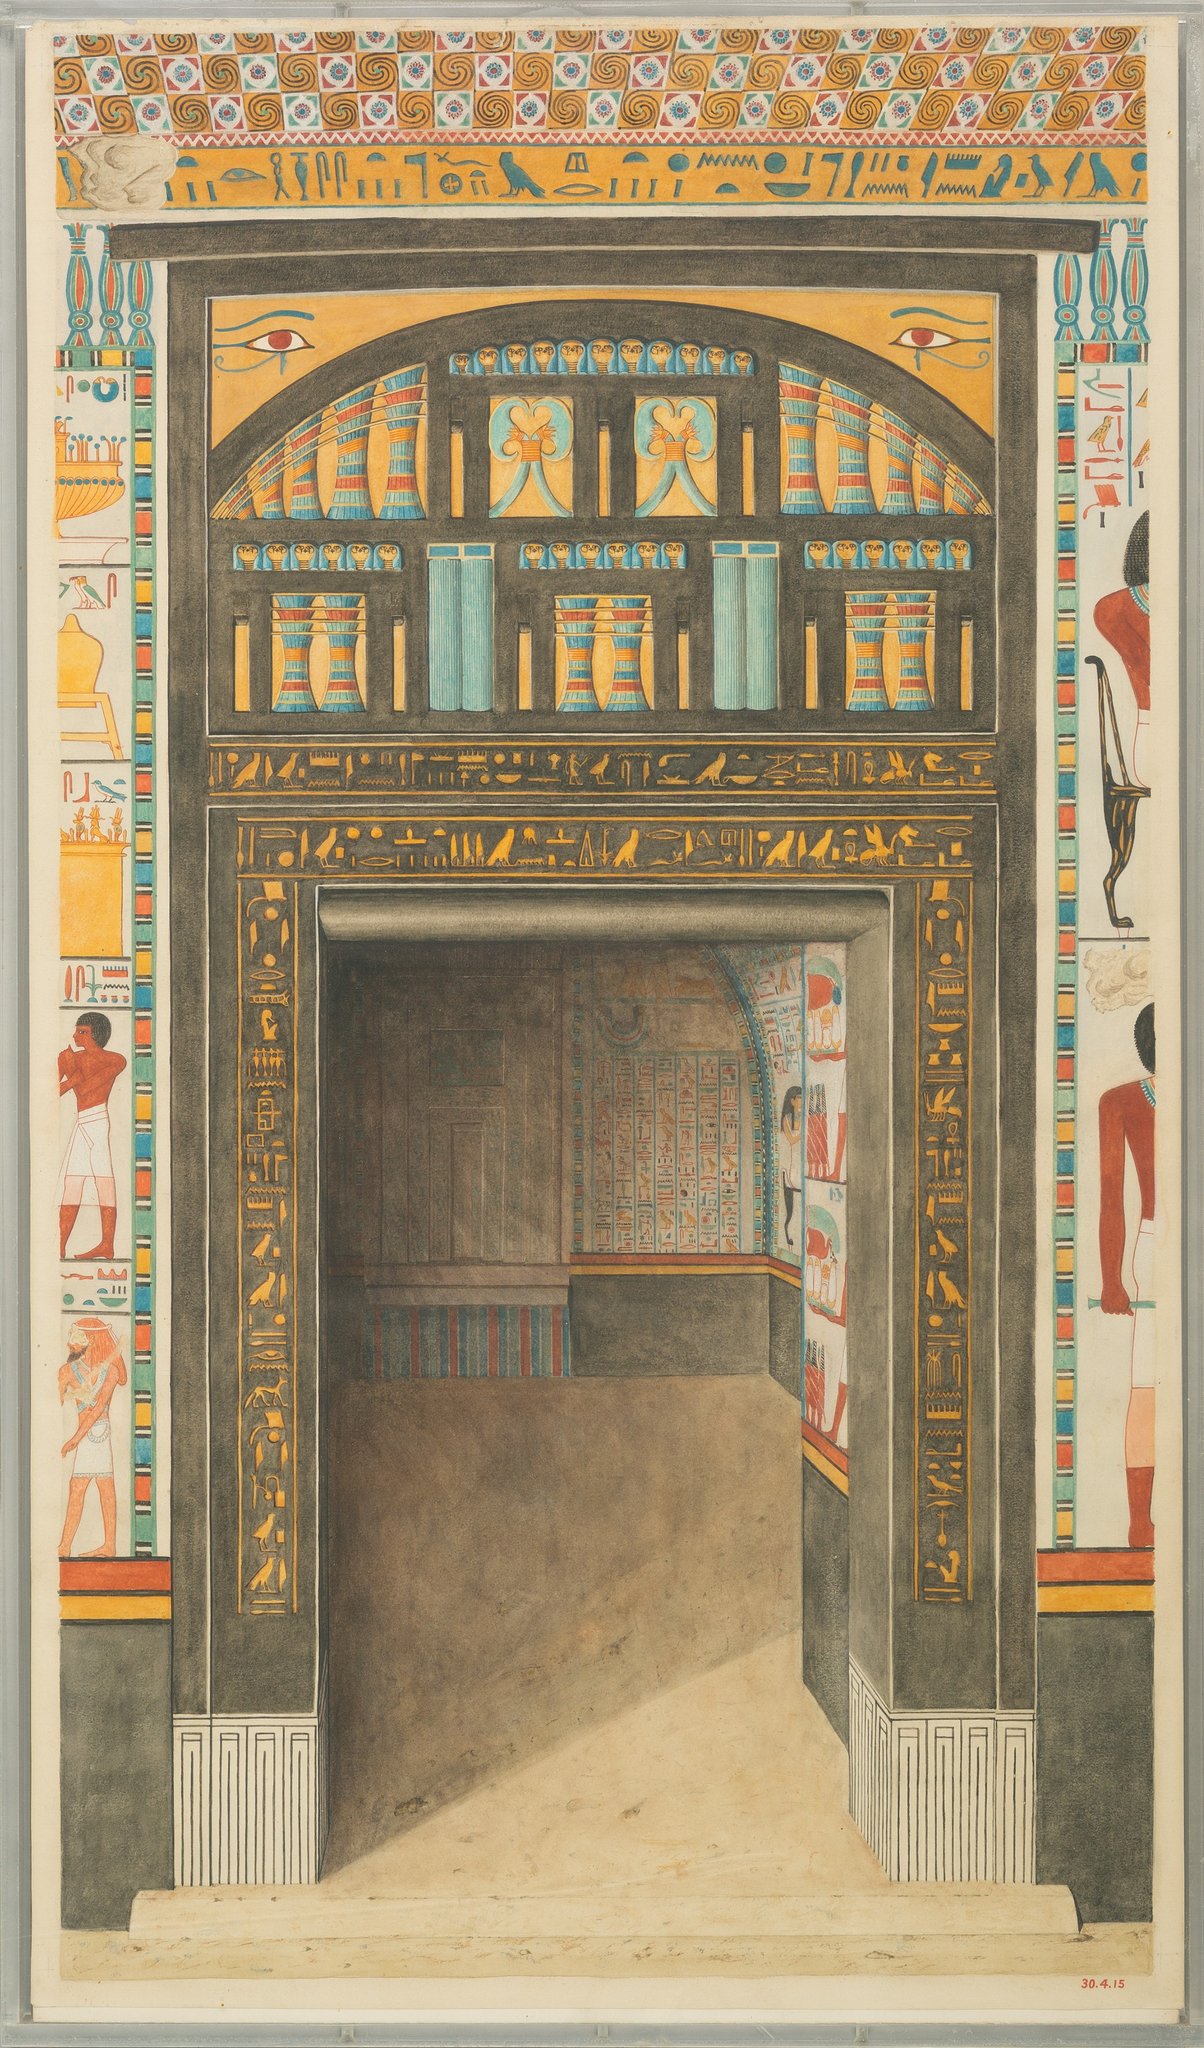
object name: facsimile, puyemre tt 39, interior, door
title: Decorated Doorway to North Chapel, Tomb of Puyemre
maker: norman de garis davies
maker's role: artist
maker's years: 1865-1941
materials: paper, paint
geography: egypt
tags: doorways,hieroglyphs,love-poetry